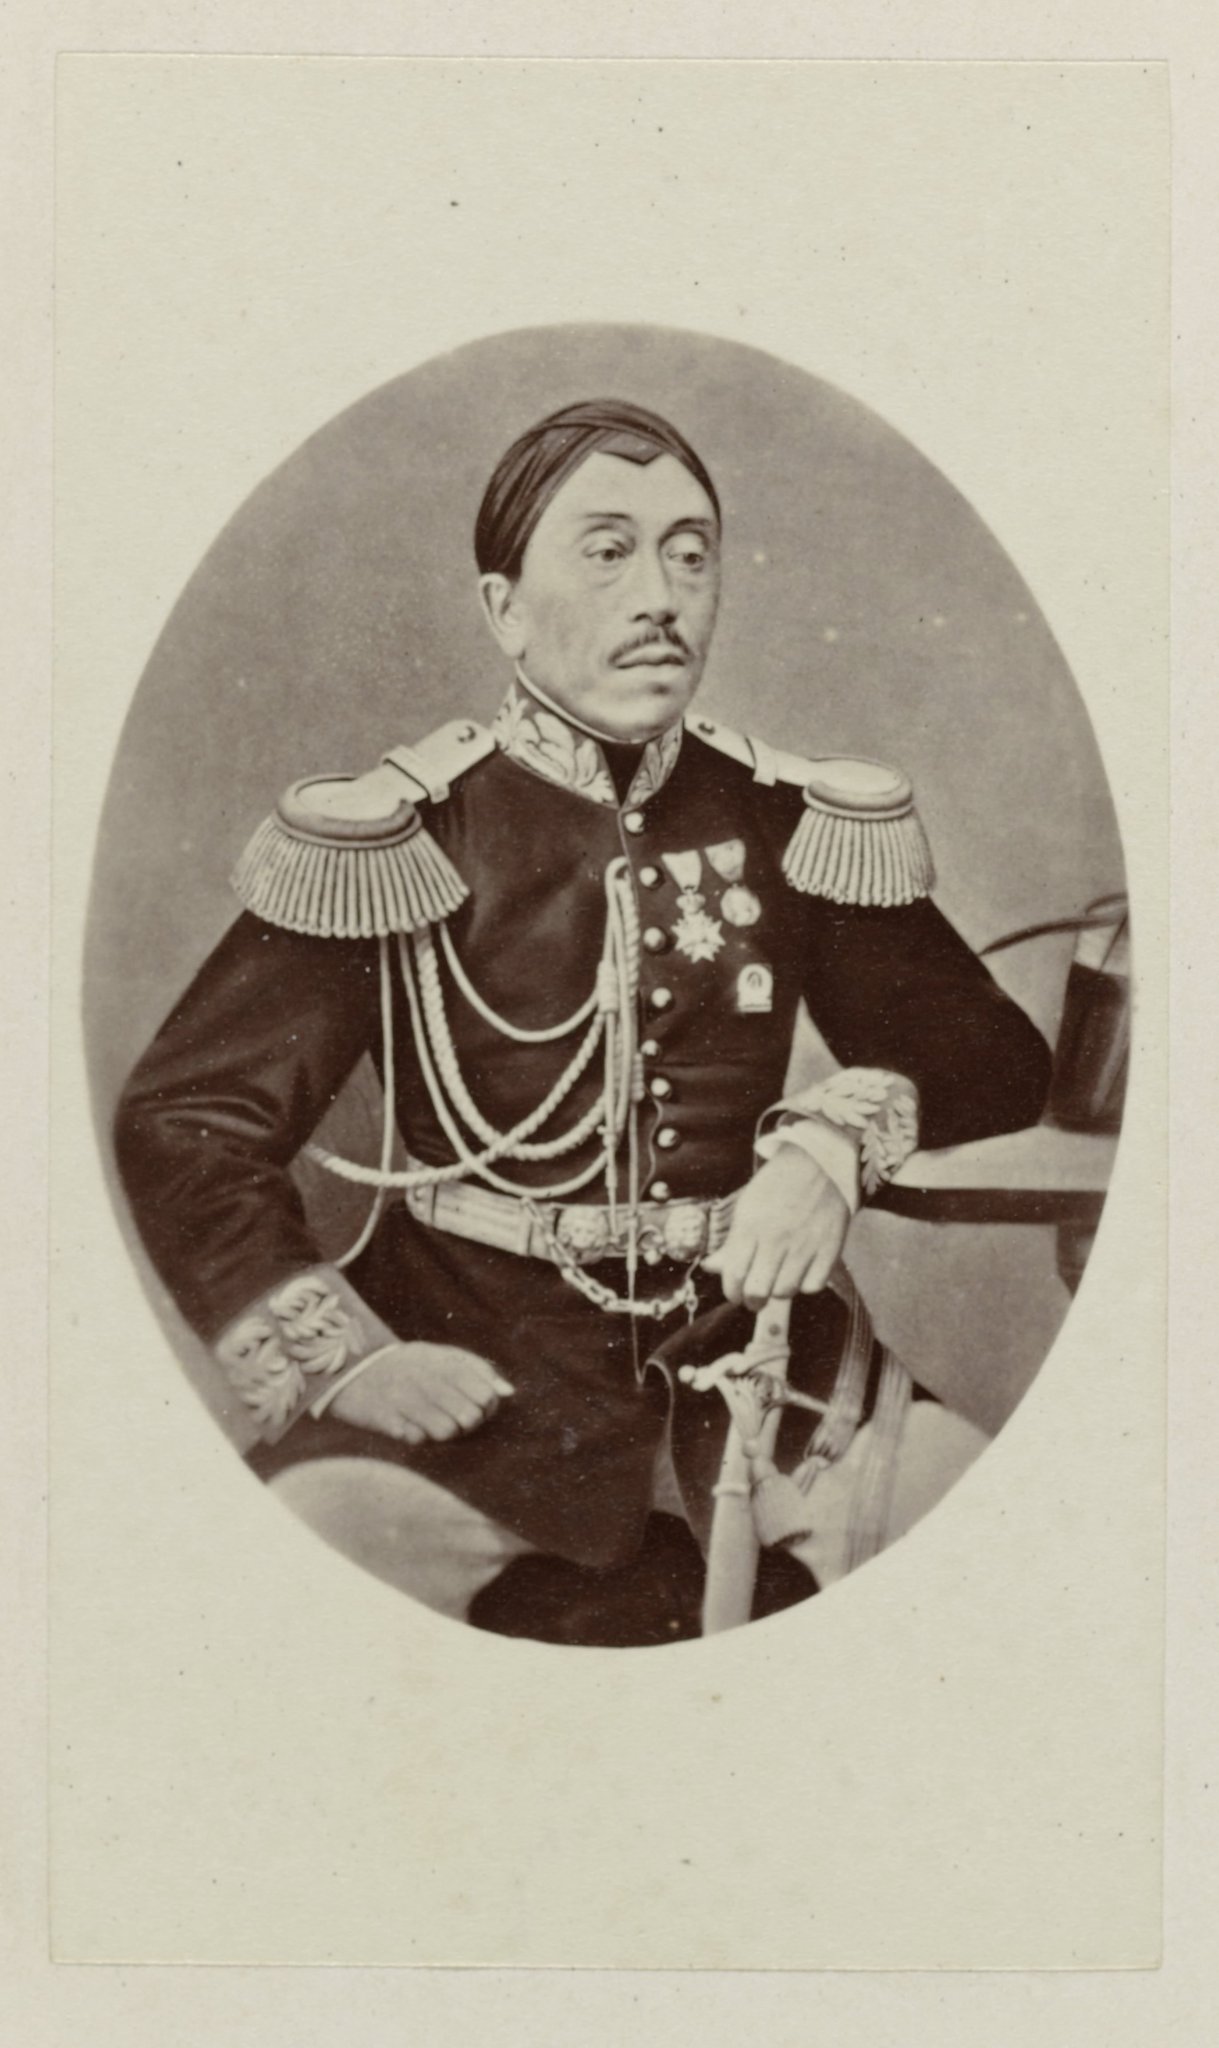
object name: photograph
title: Portret van Mangkoe Negoro IV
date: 1865-1870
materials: photographic support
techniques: albumen print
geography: batavia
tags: historical persons, java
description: Portret van de vorst Pangeran Adipati Ario Mangkoe Negoro IV, in kolonelsuniform. Ingeplakte foto in het fotoalbum getiteld: Gezichten van Java.